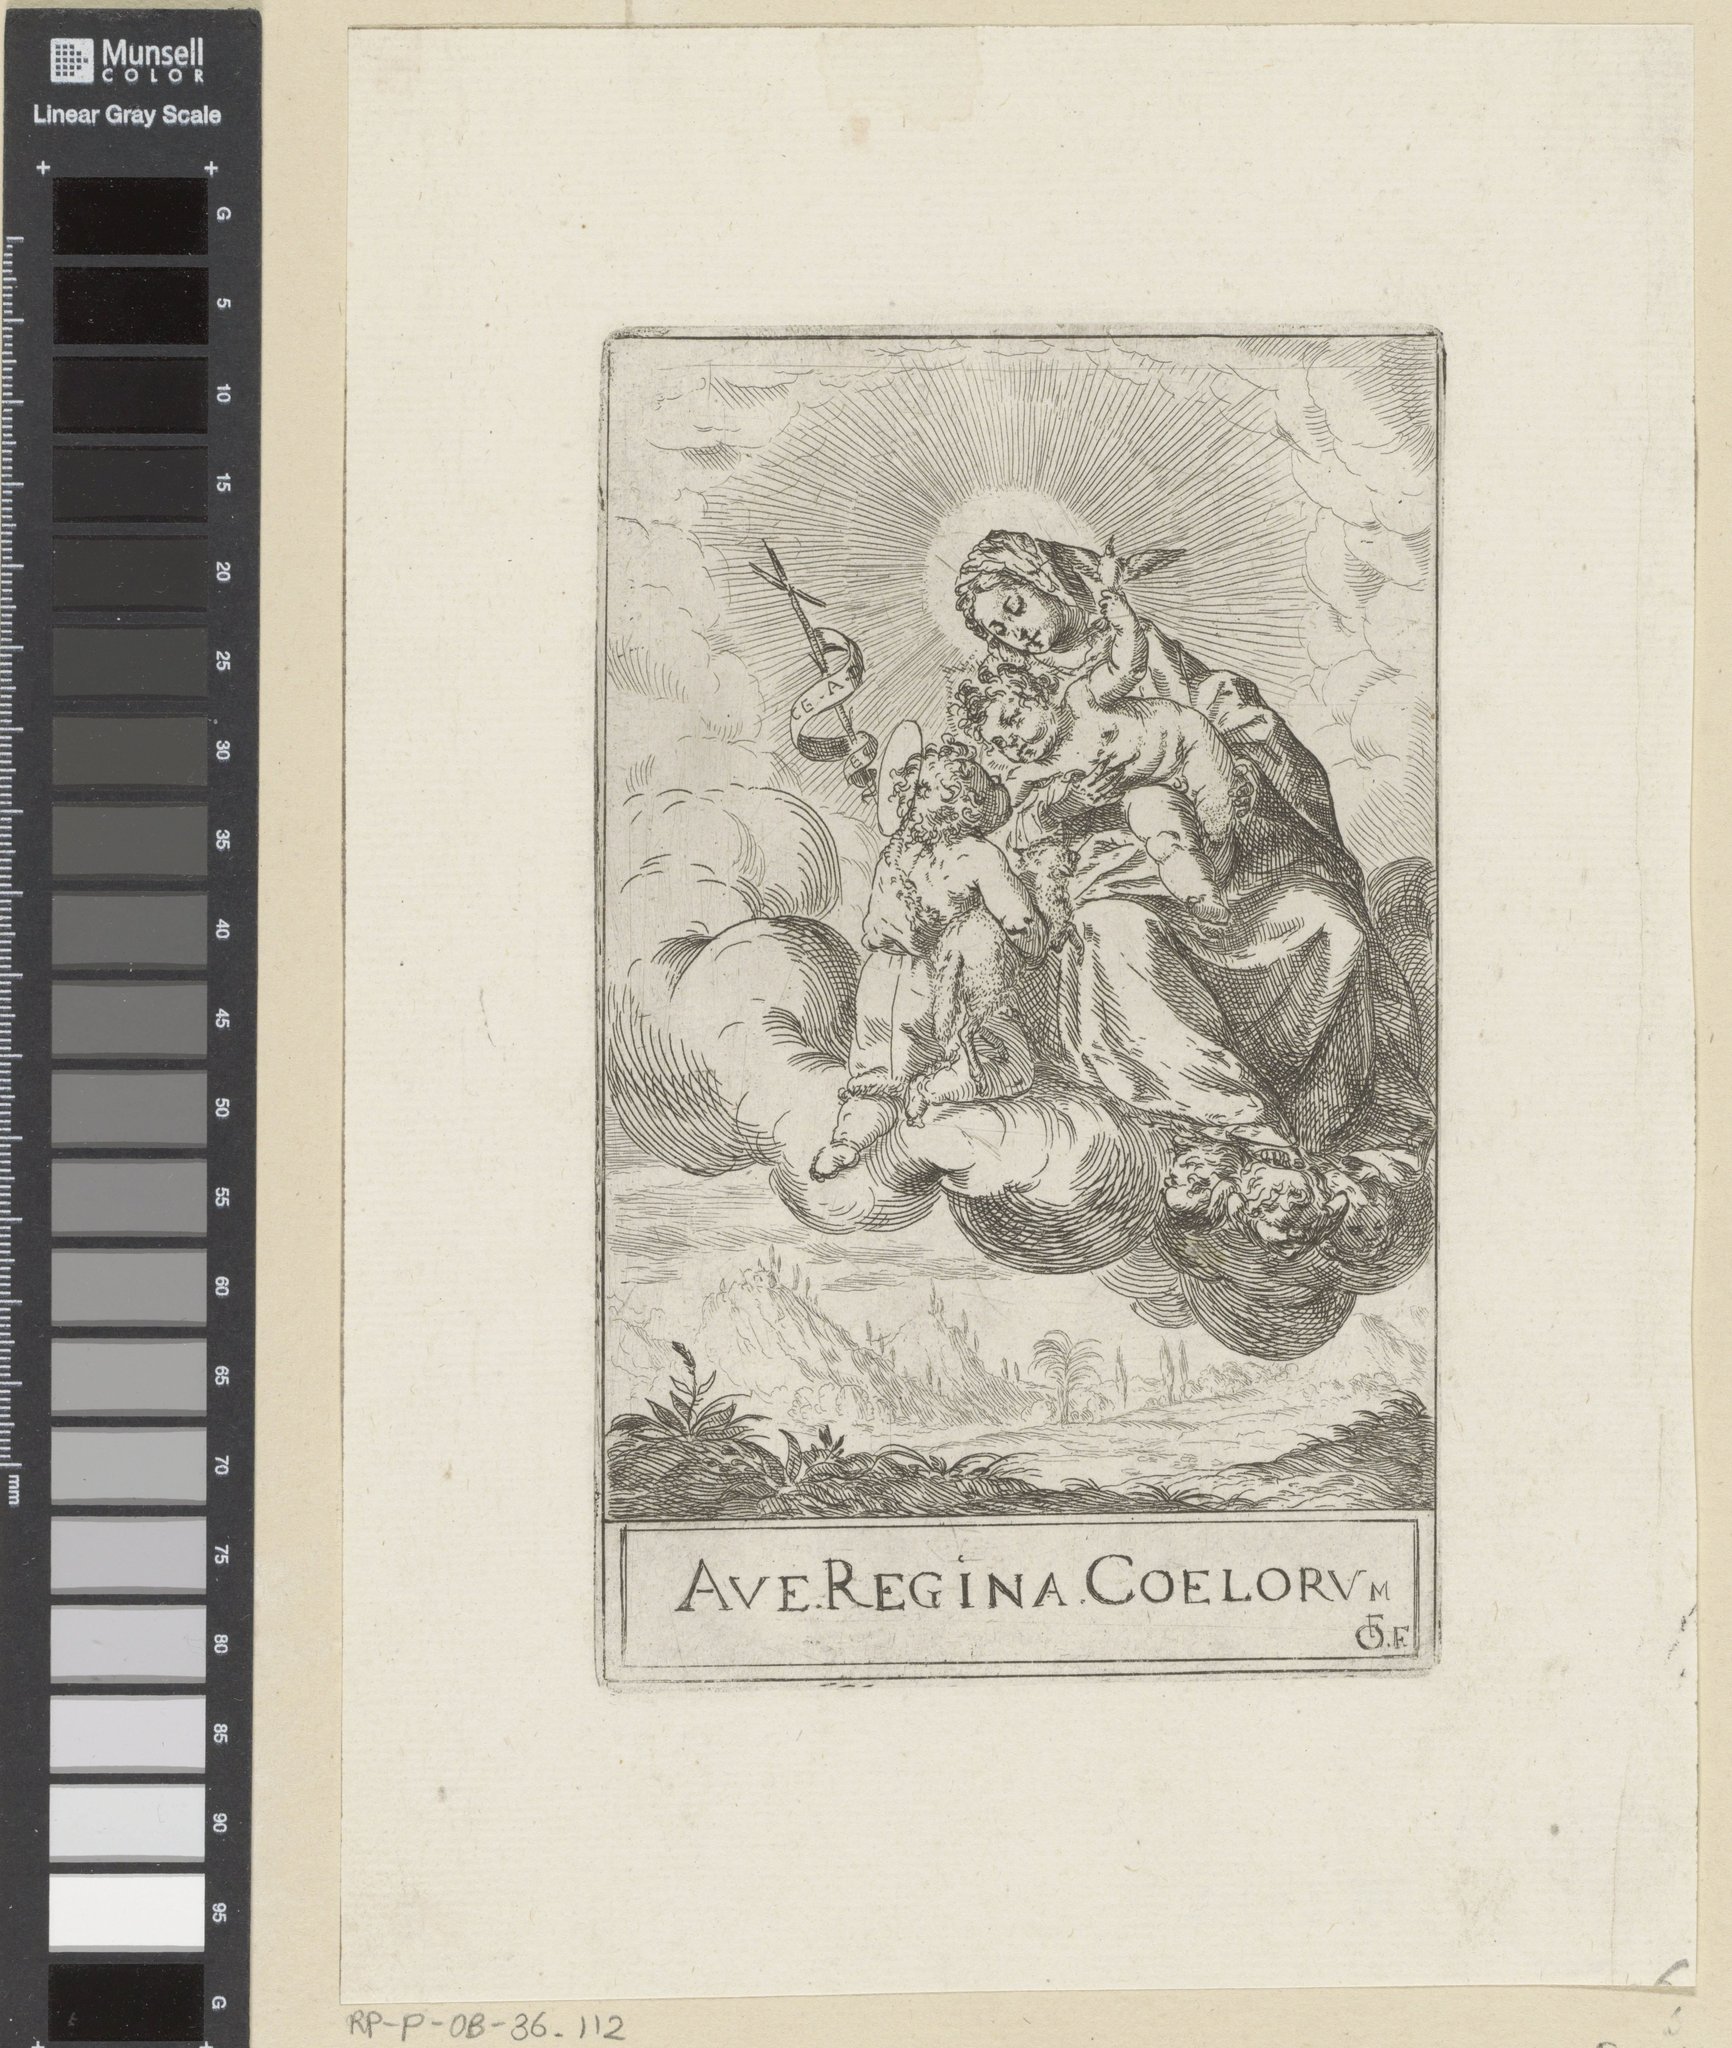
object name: print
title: Maria met Kind en de jonge Johannes de Doper op een wolk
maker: odoardo fialetti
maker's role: painter, print maker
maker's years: 1573-1638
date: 1583-1638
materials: paper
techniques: etching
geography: italy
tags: mary and the christ-child with john the baptist (as child)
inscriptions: collector's mark: Lugt 240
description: Maria zit met het Christuskind op schoot op een wolk. De jonge Johannes de Doper zit er geknield naast. Bij de voeten van Maria drie cherubijnen. Beneden een landschap. Titel in ondermarge.